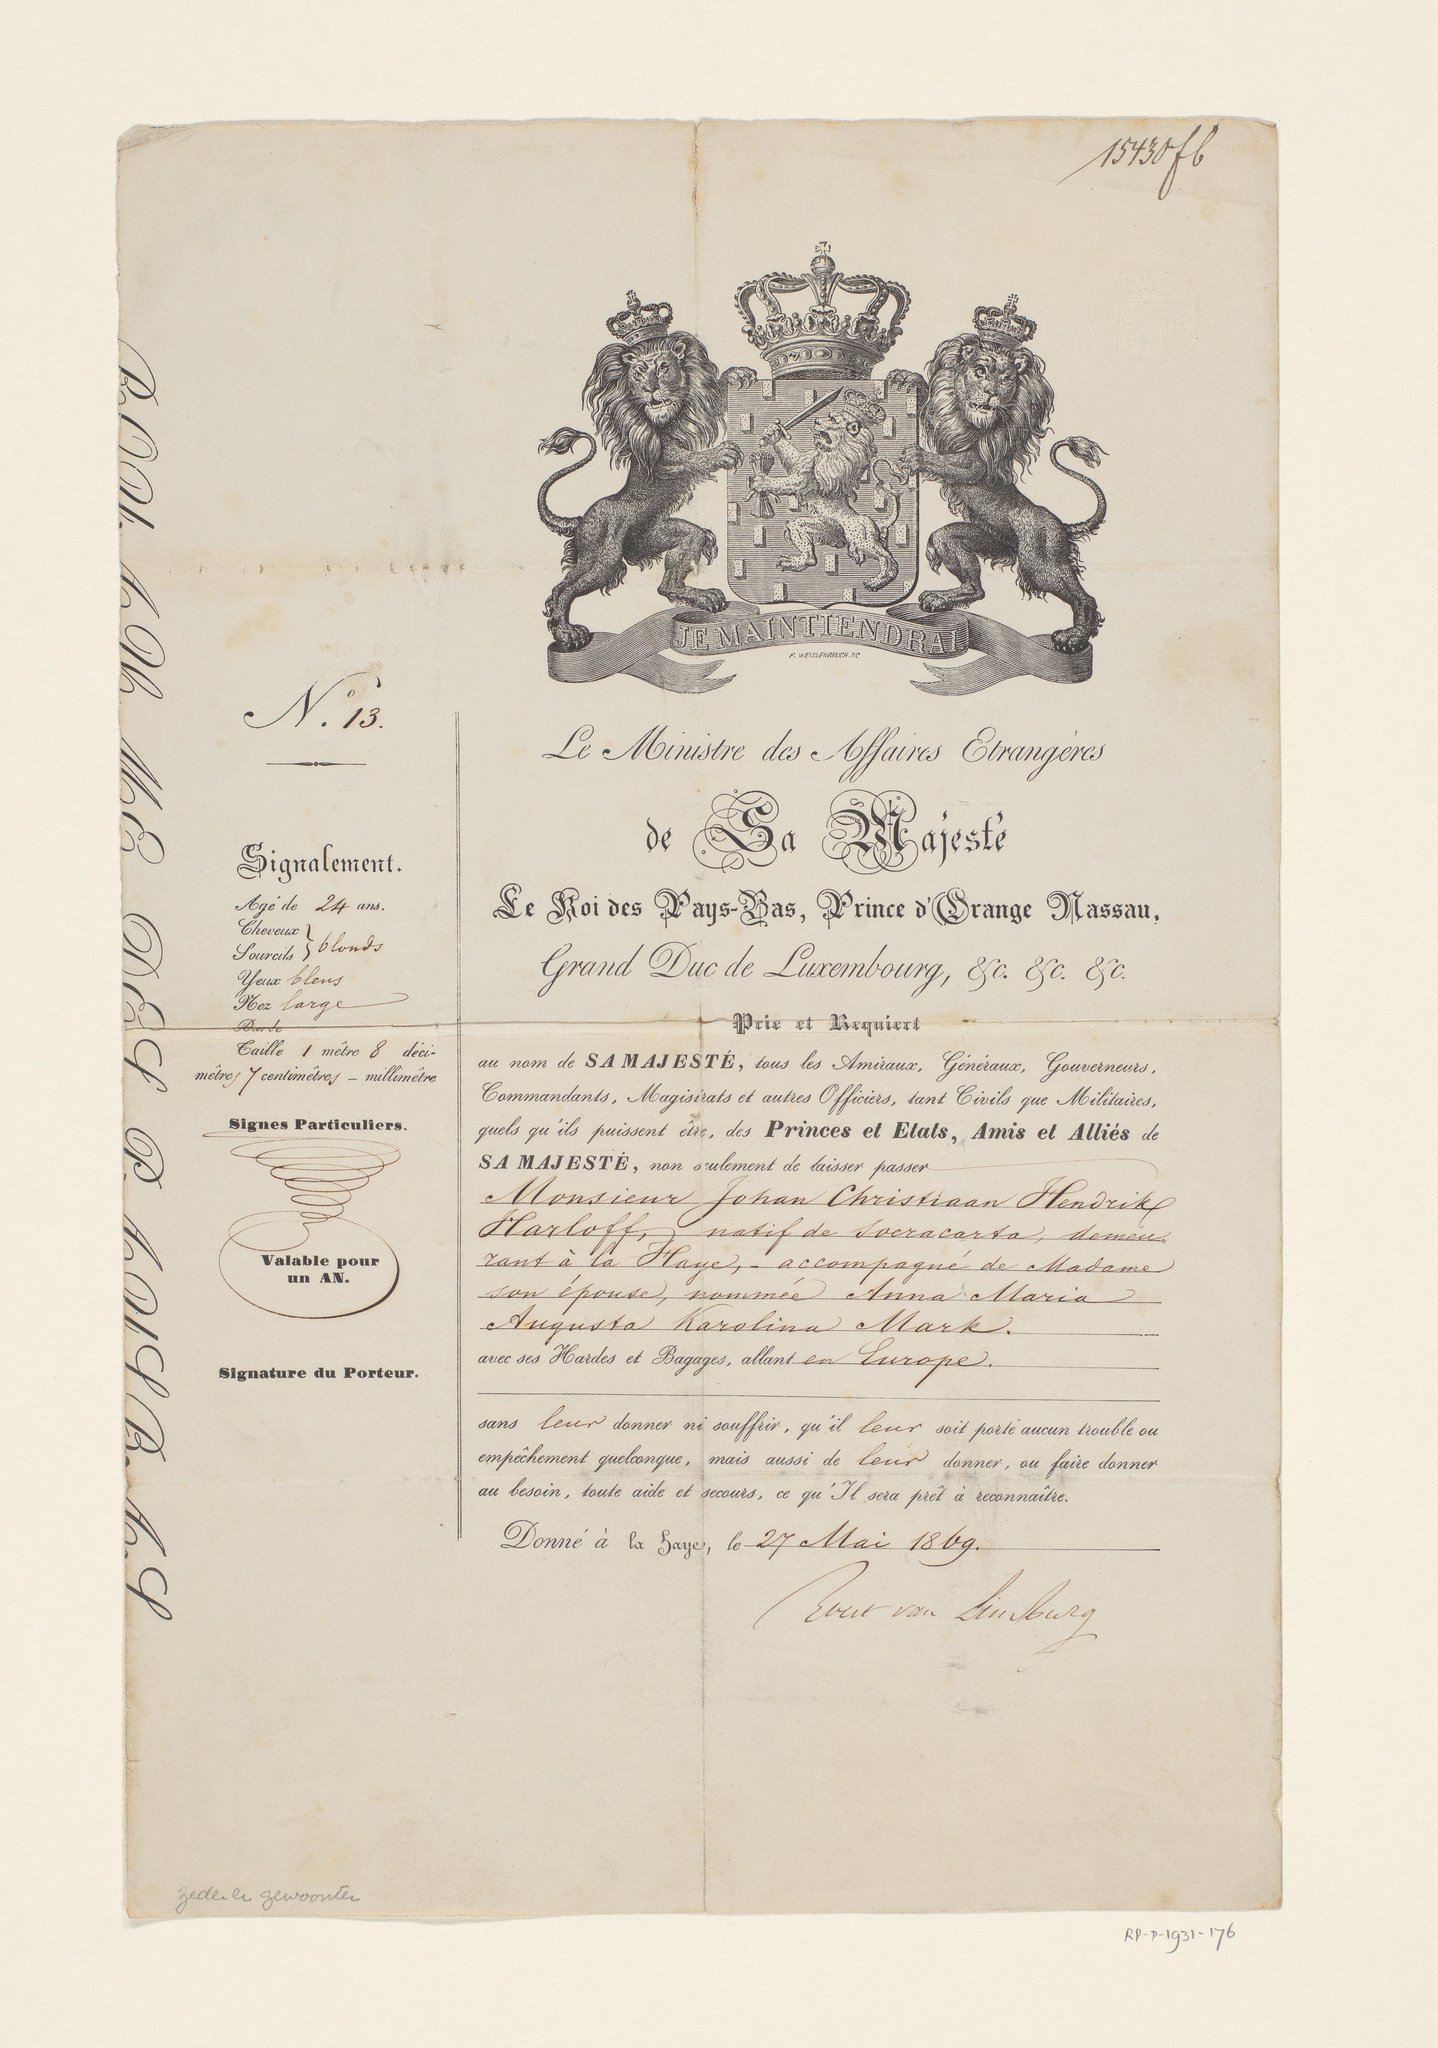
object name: passport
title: Paspoort op naam van Johan Christiaan Hendrik Harloff en zijn vrouw Anna Maria Augusta Karolina Mark, 27 mei 1869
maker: frederik hendrik weissenbruch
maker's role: draughtsman, print maker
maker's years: 1828-1887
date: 1840-1869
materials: paper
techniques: handwriting, engraving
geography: netherlands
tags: passport, visa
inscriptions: collector's mark: Lugt 2228, stamp: ‘5. Gl.’, collector's mark: Lugt 2233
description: Paspoort op naam van Johan Christiaan Hendrik Harloff en zijn vrouw Anna Maria Augusta Karolina Mark. Voorgedrukt blad met tekst en bovenaan een vignet met het wapen van Nederland, met de hand ingevuld te Den Haag op 27 mei 1869 door '... van Limburg'.